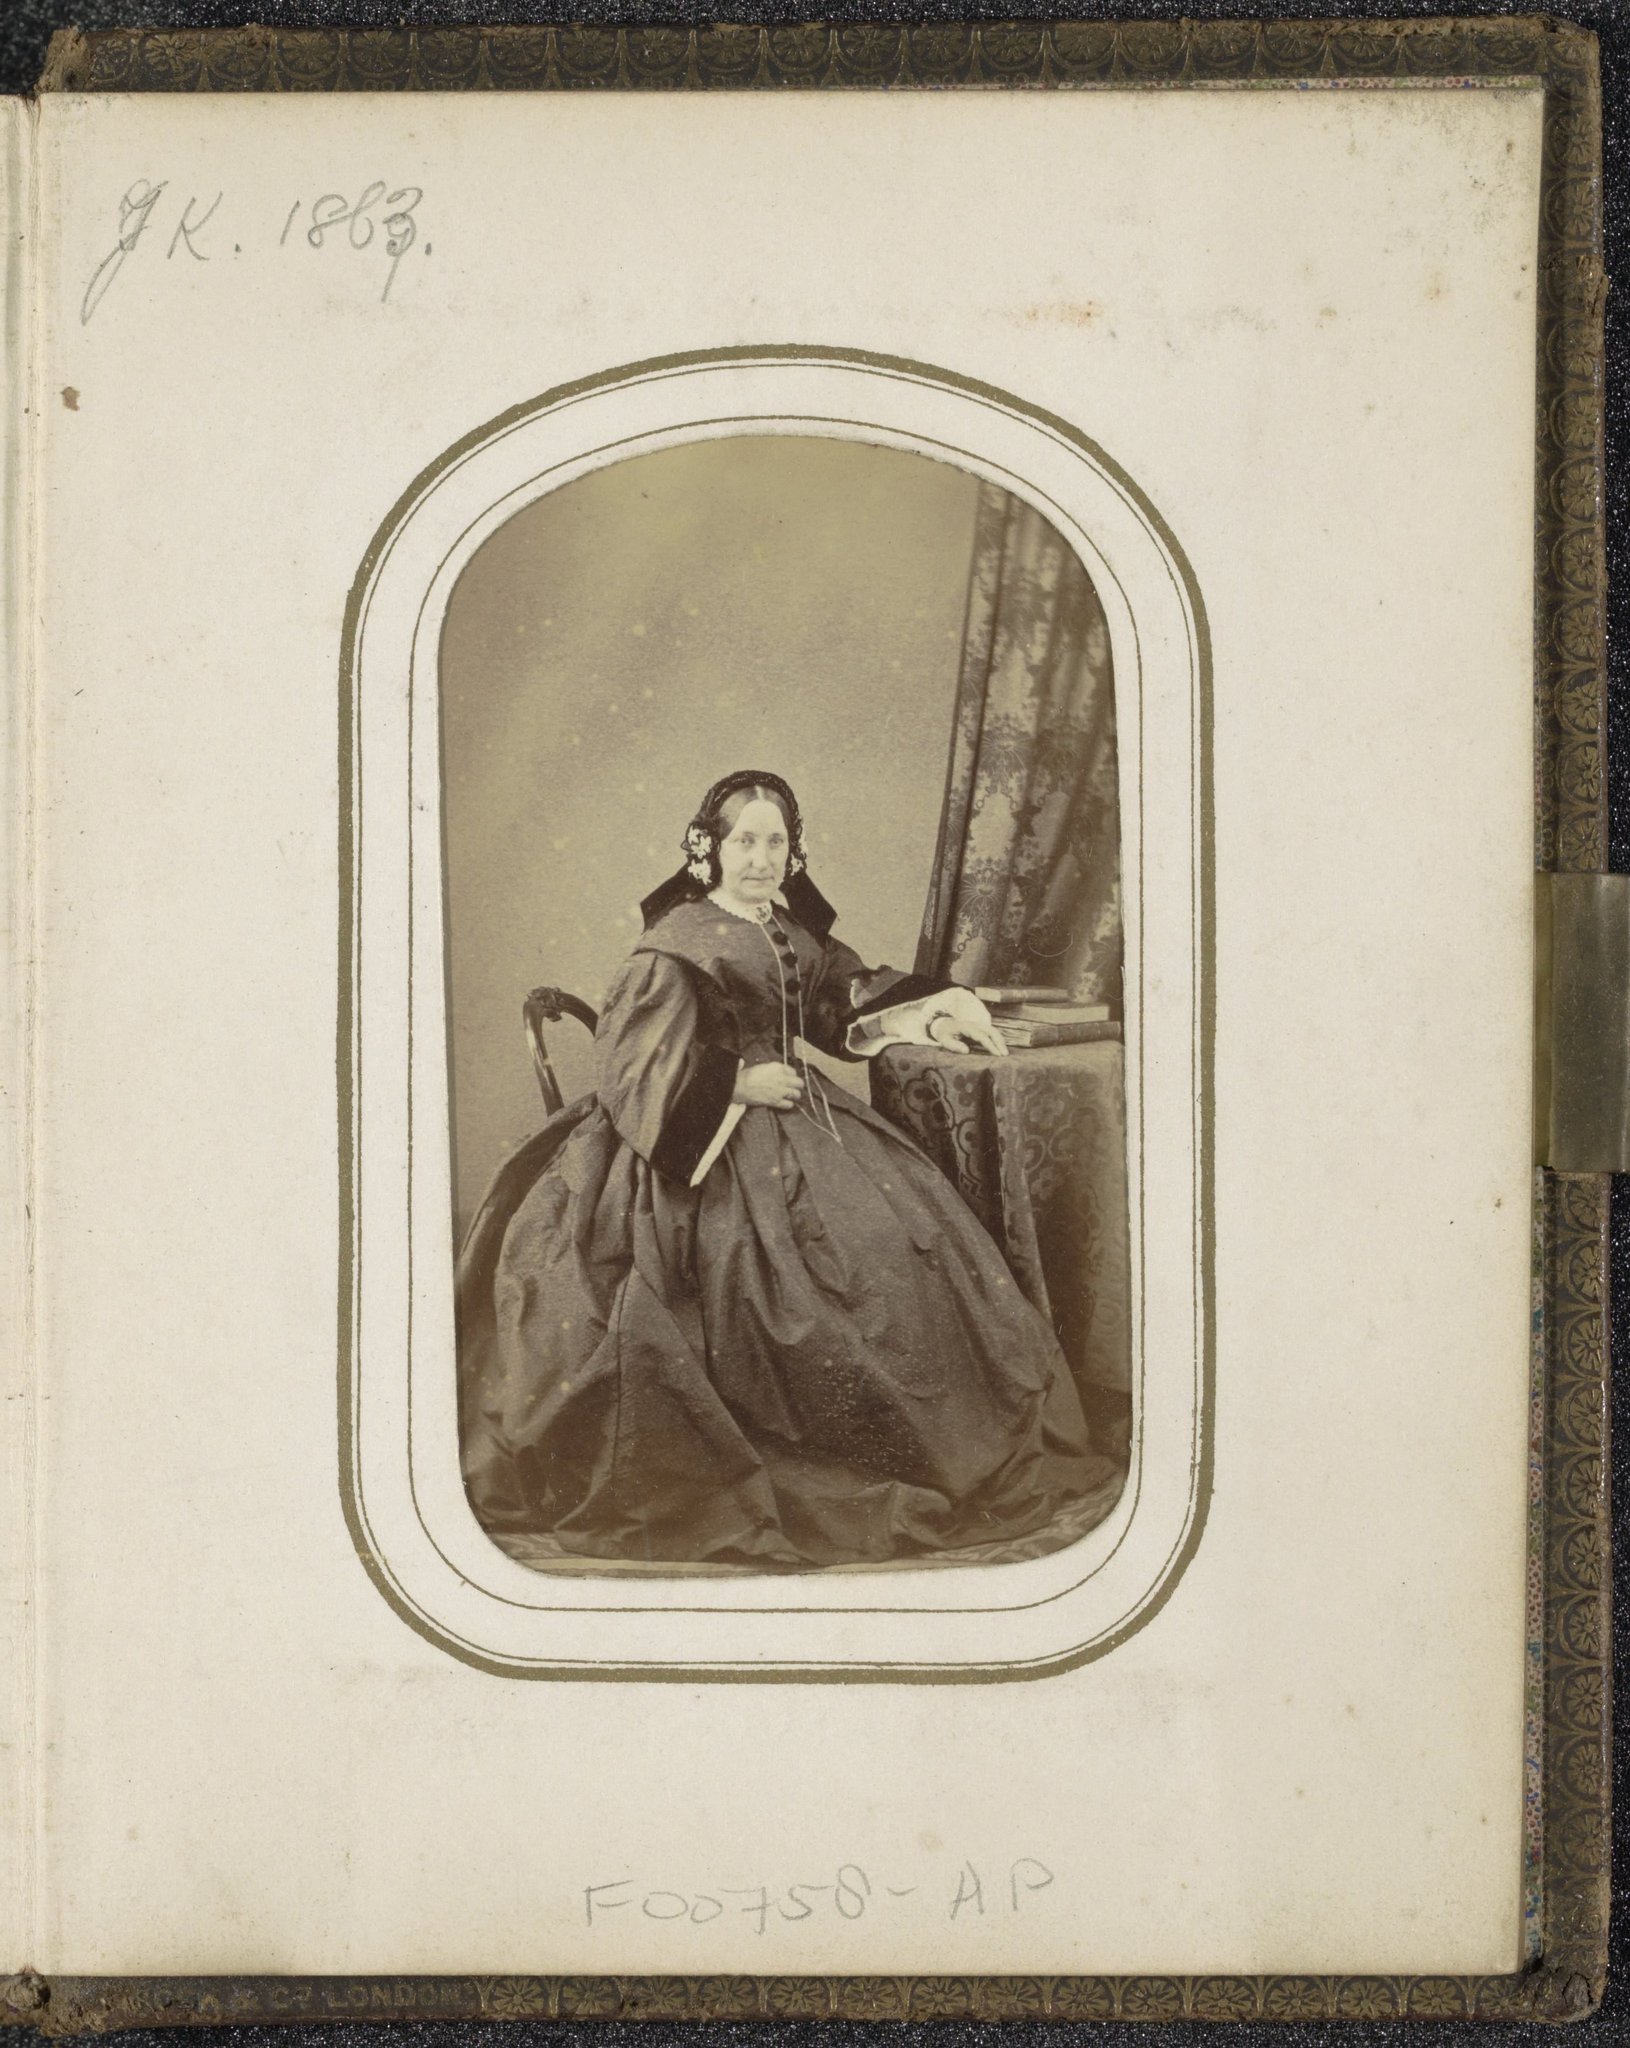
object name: photograph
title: Portret van een zittende vrouw, aangeduid al JK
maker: e. andrews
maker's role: fotograaf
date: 1863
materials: cardboard, paper, photographic support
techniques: albumen print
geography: guildford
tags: studio requisites ~ photographer, clothing for the lower part of the body, historical persons, clothing for the upper part of the body, head-gear: hat, book, necklace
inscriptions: inscription: ‘JK. 1863.’, address: ‘Guildford, 50 Chertsey Street’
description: Onderdeel van Engels fotoalbum van E.A. Kettle met 42 cartes-de-visite.